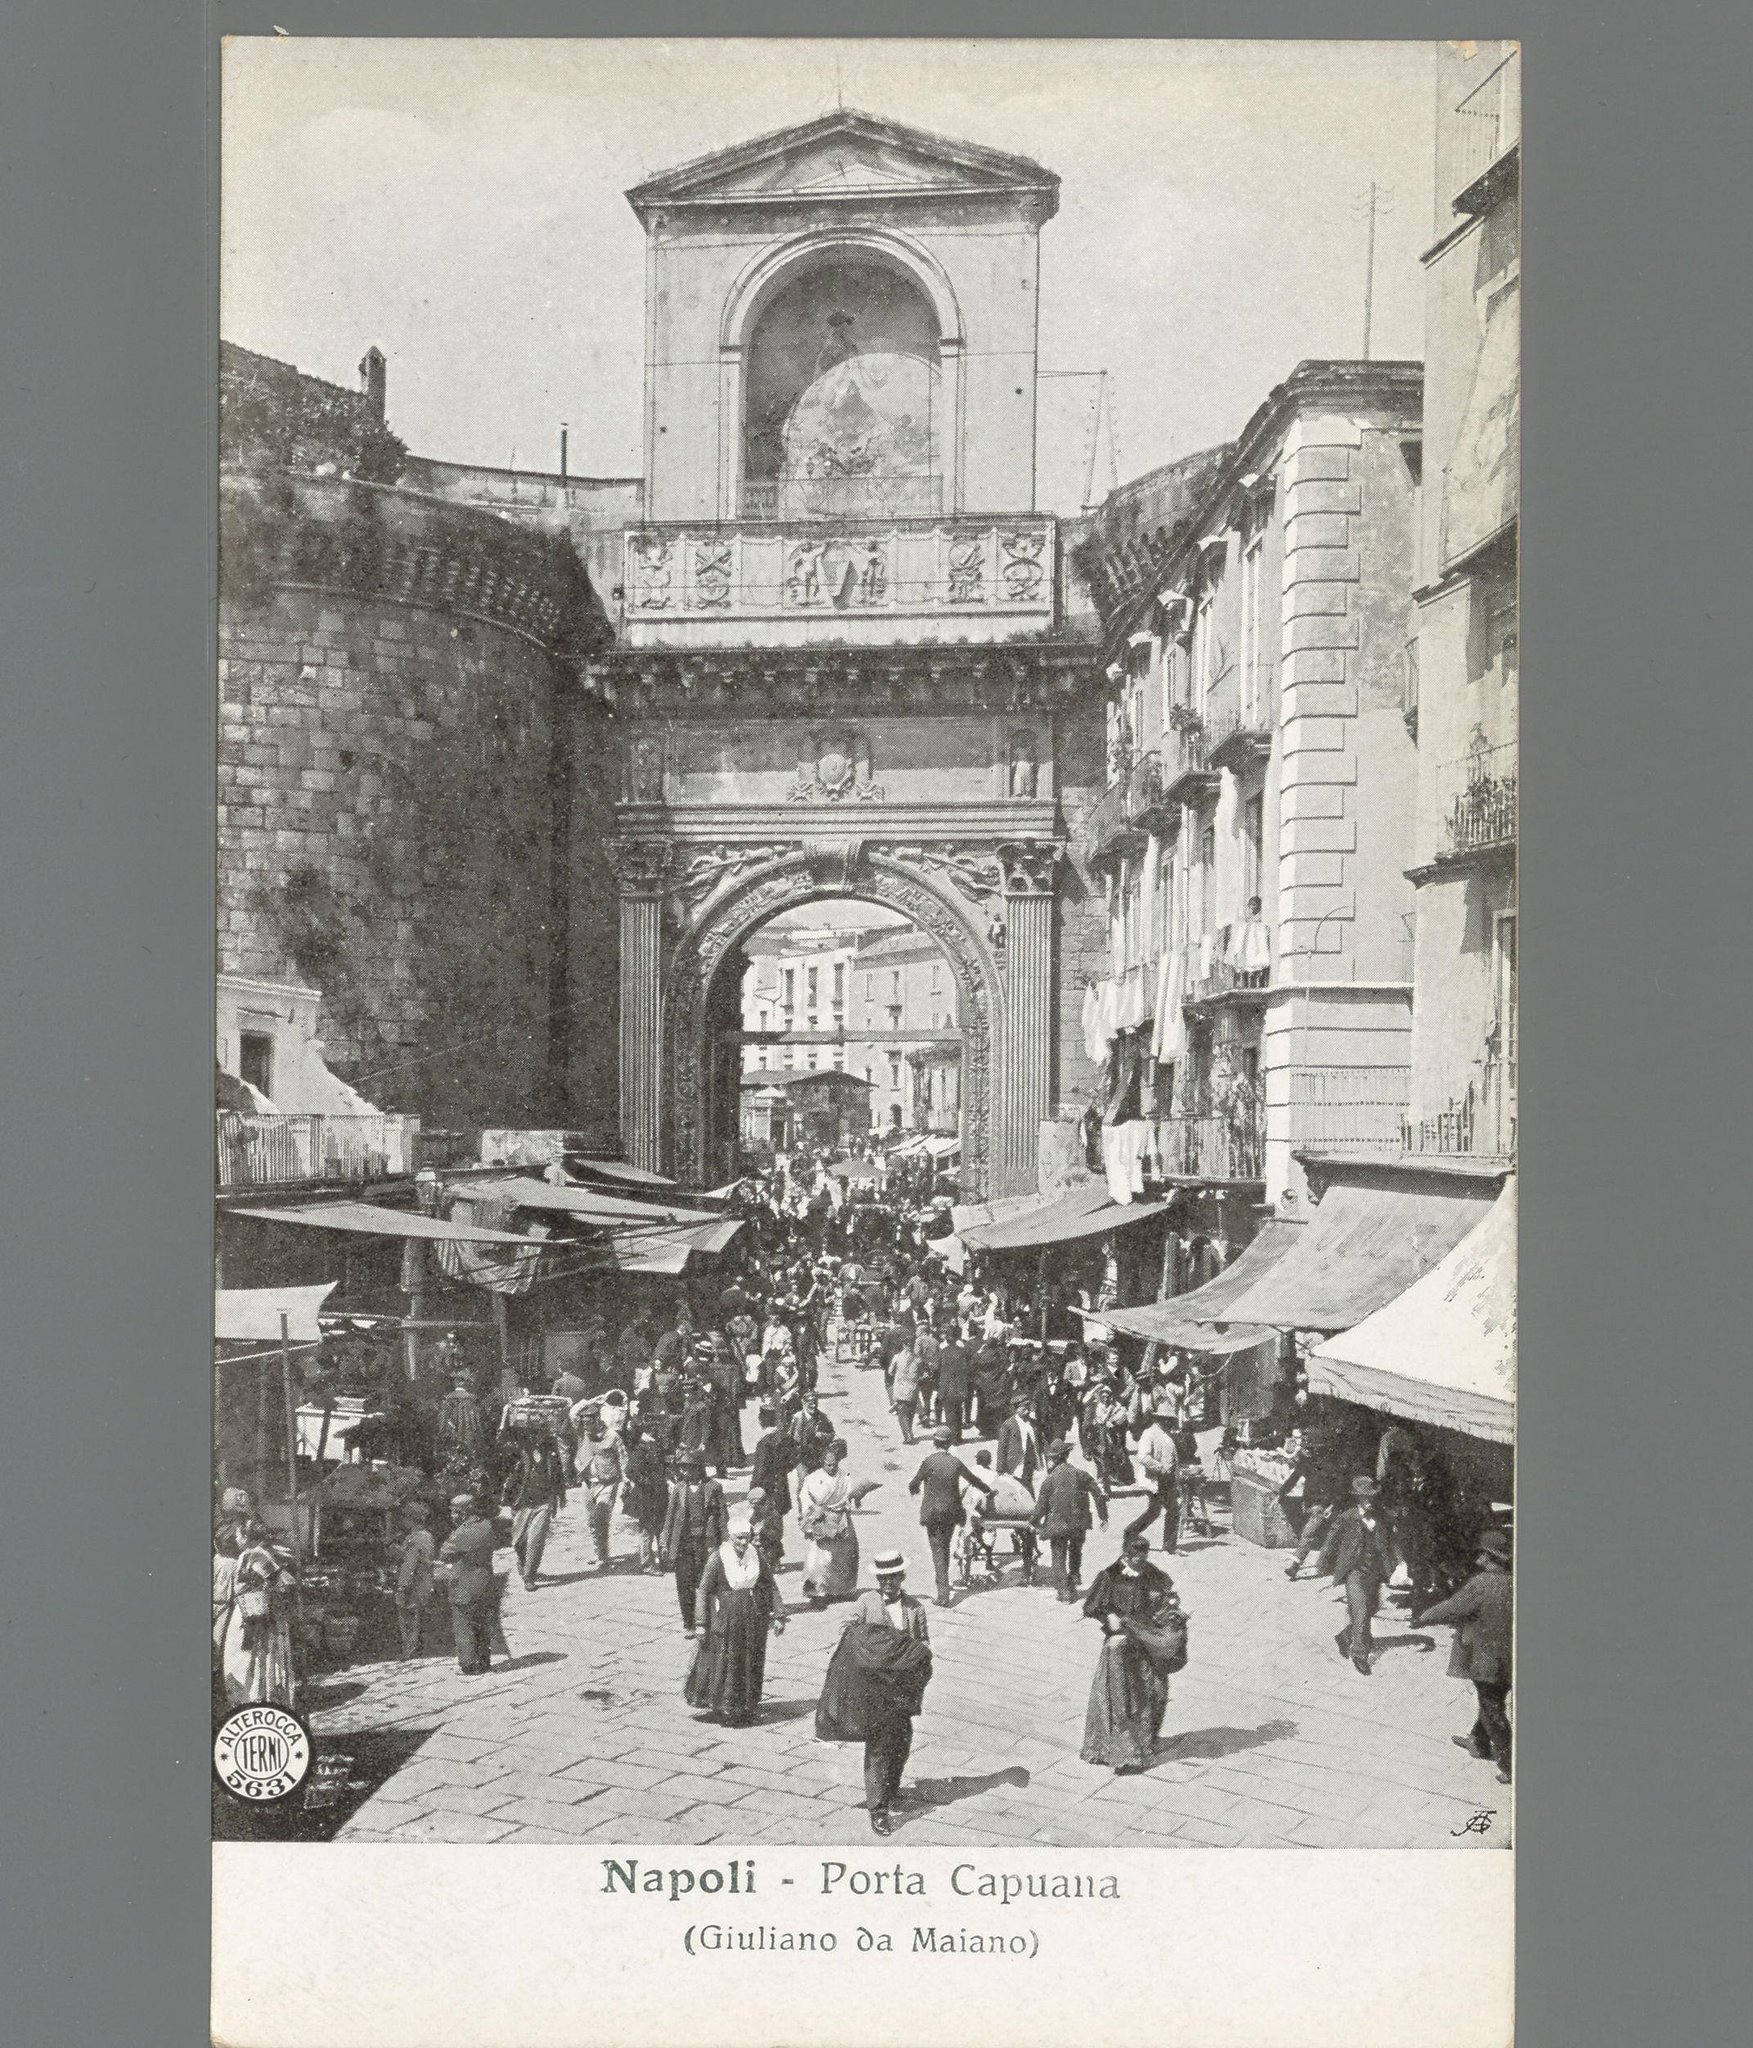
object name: photomechanical print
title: Napoli. Porta Capuana (Giuliano da Maiano)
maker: Anonymous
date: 1906-1910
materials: cardboard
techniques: autotype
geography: terni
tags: city-view, and landscape with man-made constructions (+ city(-scape) with figures, staffage), city-gate (+ city(-scape) with figures, staffage)